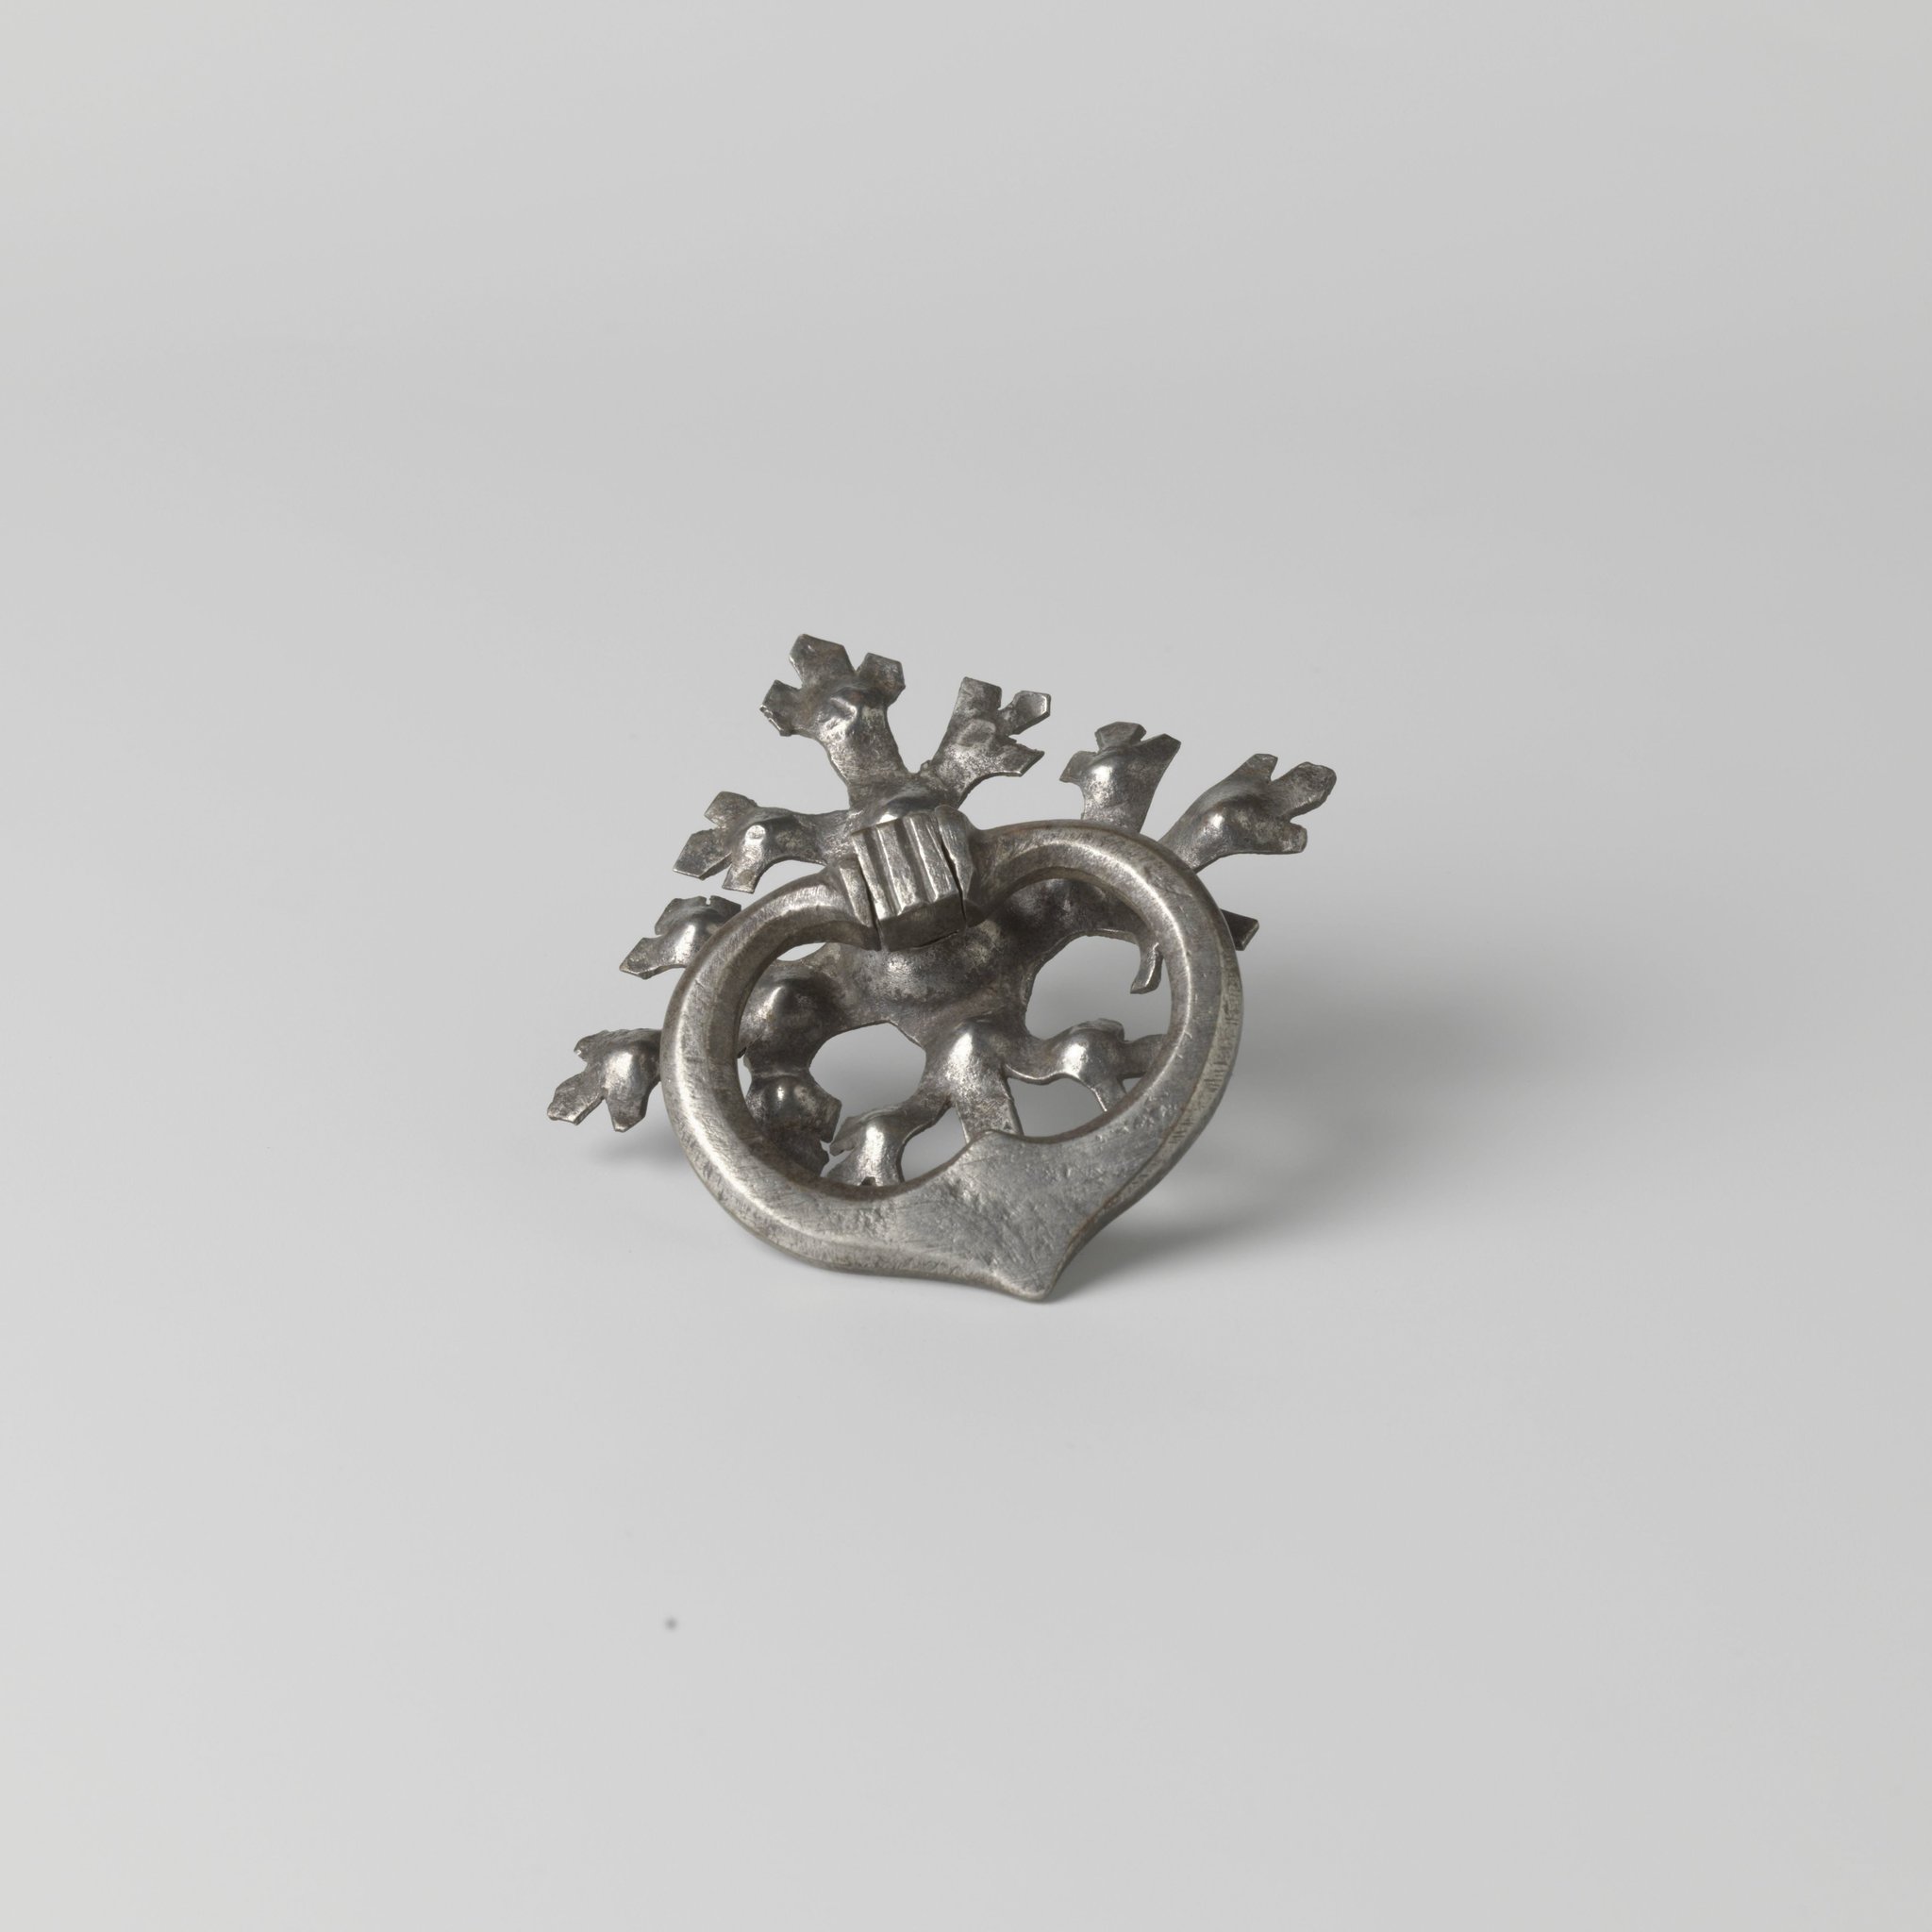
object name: door knocker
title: Deurklopper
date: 1400-1950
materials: iron